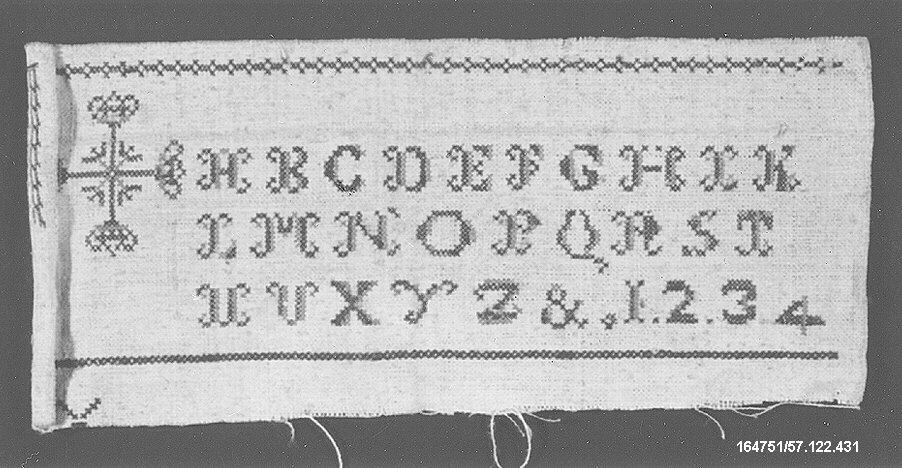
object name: sampler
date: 1801-1900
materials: linen, silk